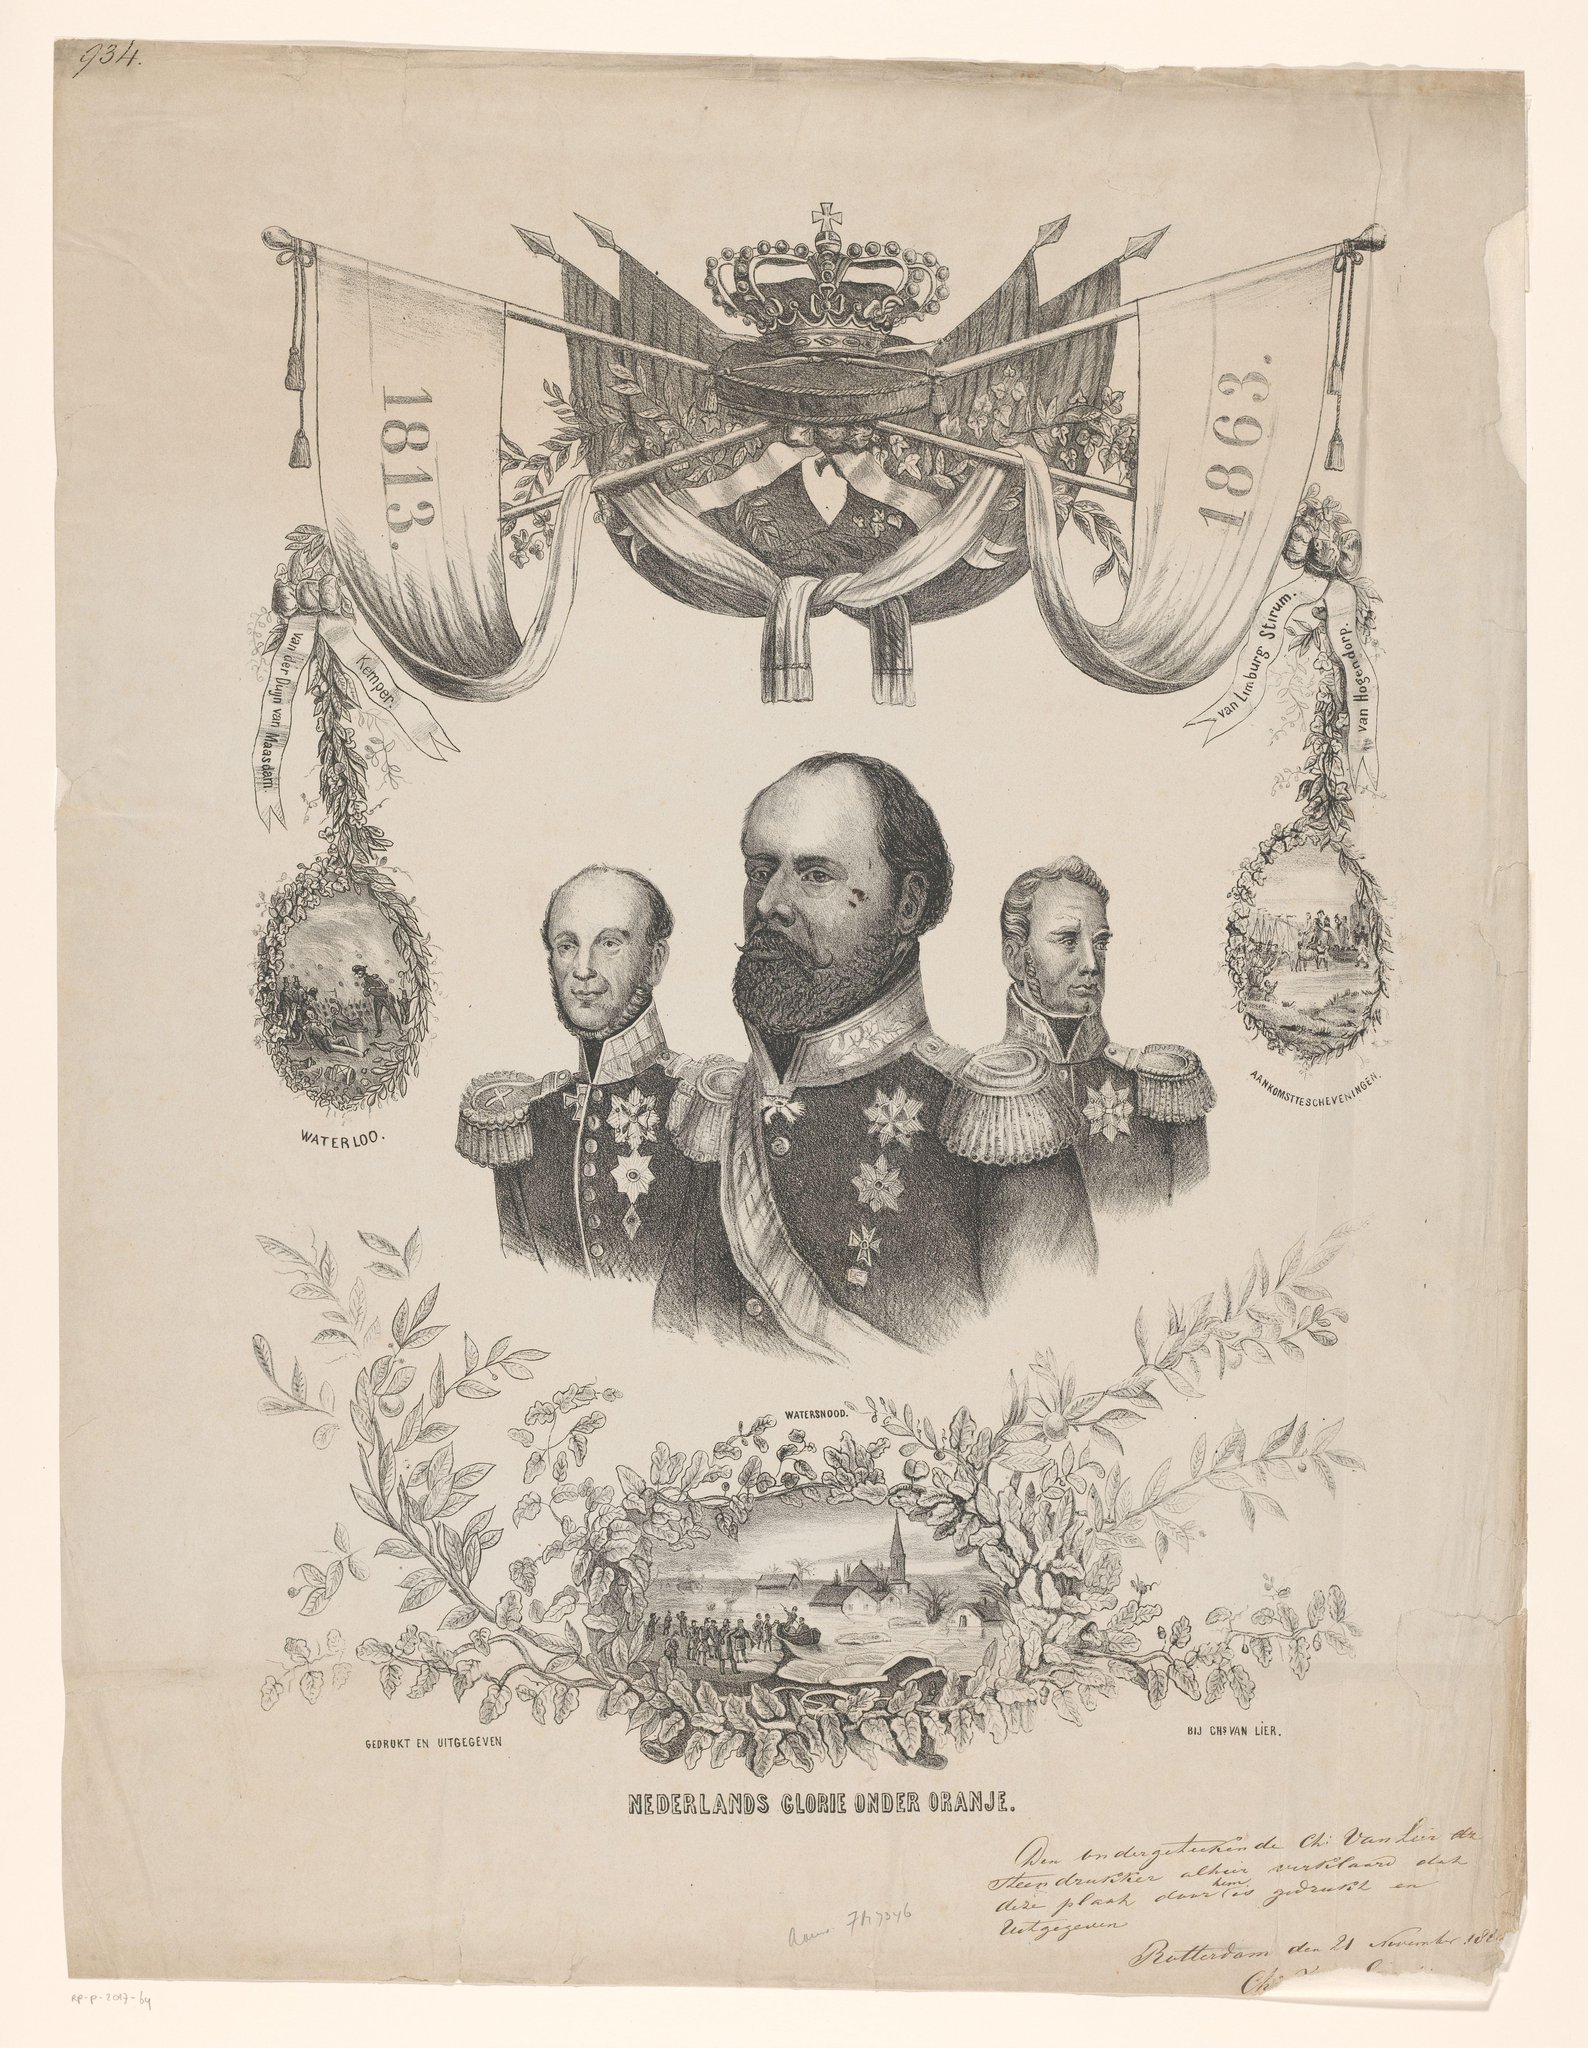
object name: print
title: Nederlands glorie onder oranje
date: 1863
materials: paper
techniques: lithograph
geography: rotterdam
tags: the hague, berlin, william i of the netherlands, brussels, willem iii (koning der nederlanden), william ii of the netherlands, flood, historical persons (+ (full) bust portrait), waterloo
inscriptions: : ‘Den ondergeteekende Ch van Lier / steendrukker alhier verklaard dat / deze plaat door hem is gedrukt en / uitgegeven / Rotterdam den 21 November 186(...) / Ch (...)’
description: Boven de portretten een kroon en vaandels met daarop de jaartallen 1813 en 1863. In bloemenkransen scènes die verwijzen naar de slag bij Waterloo en de landing van de latere Koning Willem I te Scheveningen. Onderin een tafereel dat verwijst naar de watersnoodramp in 1861.